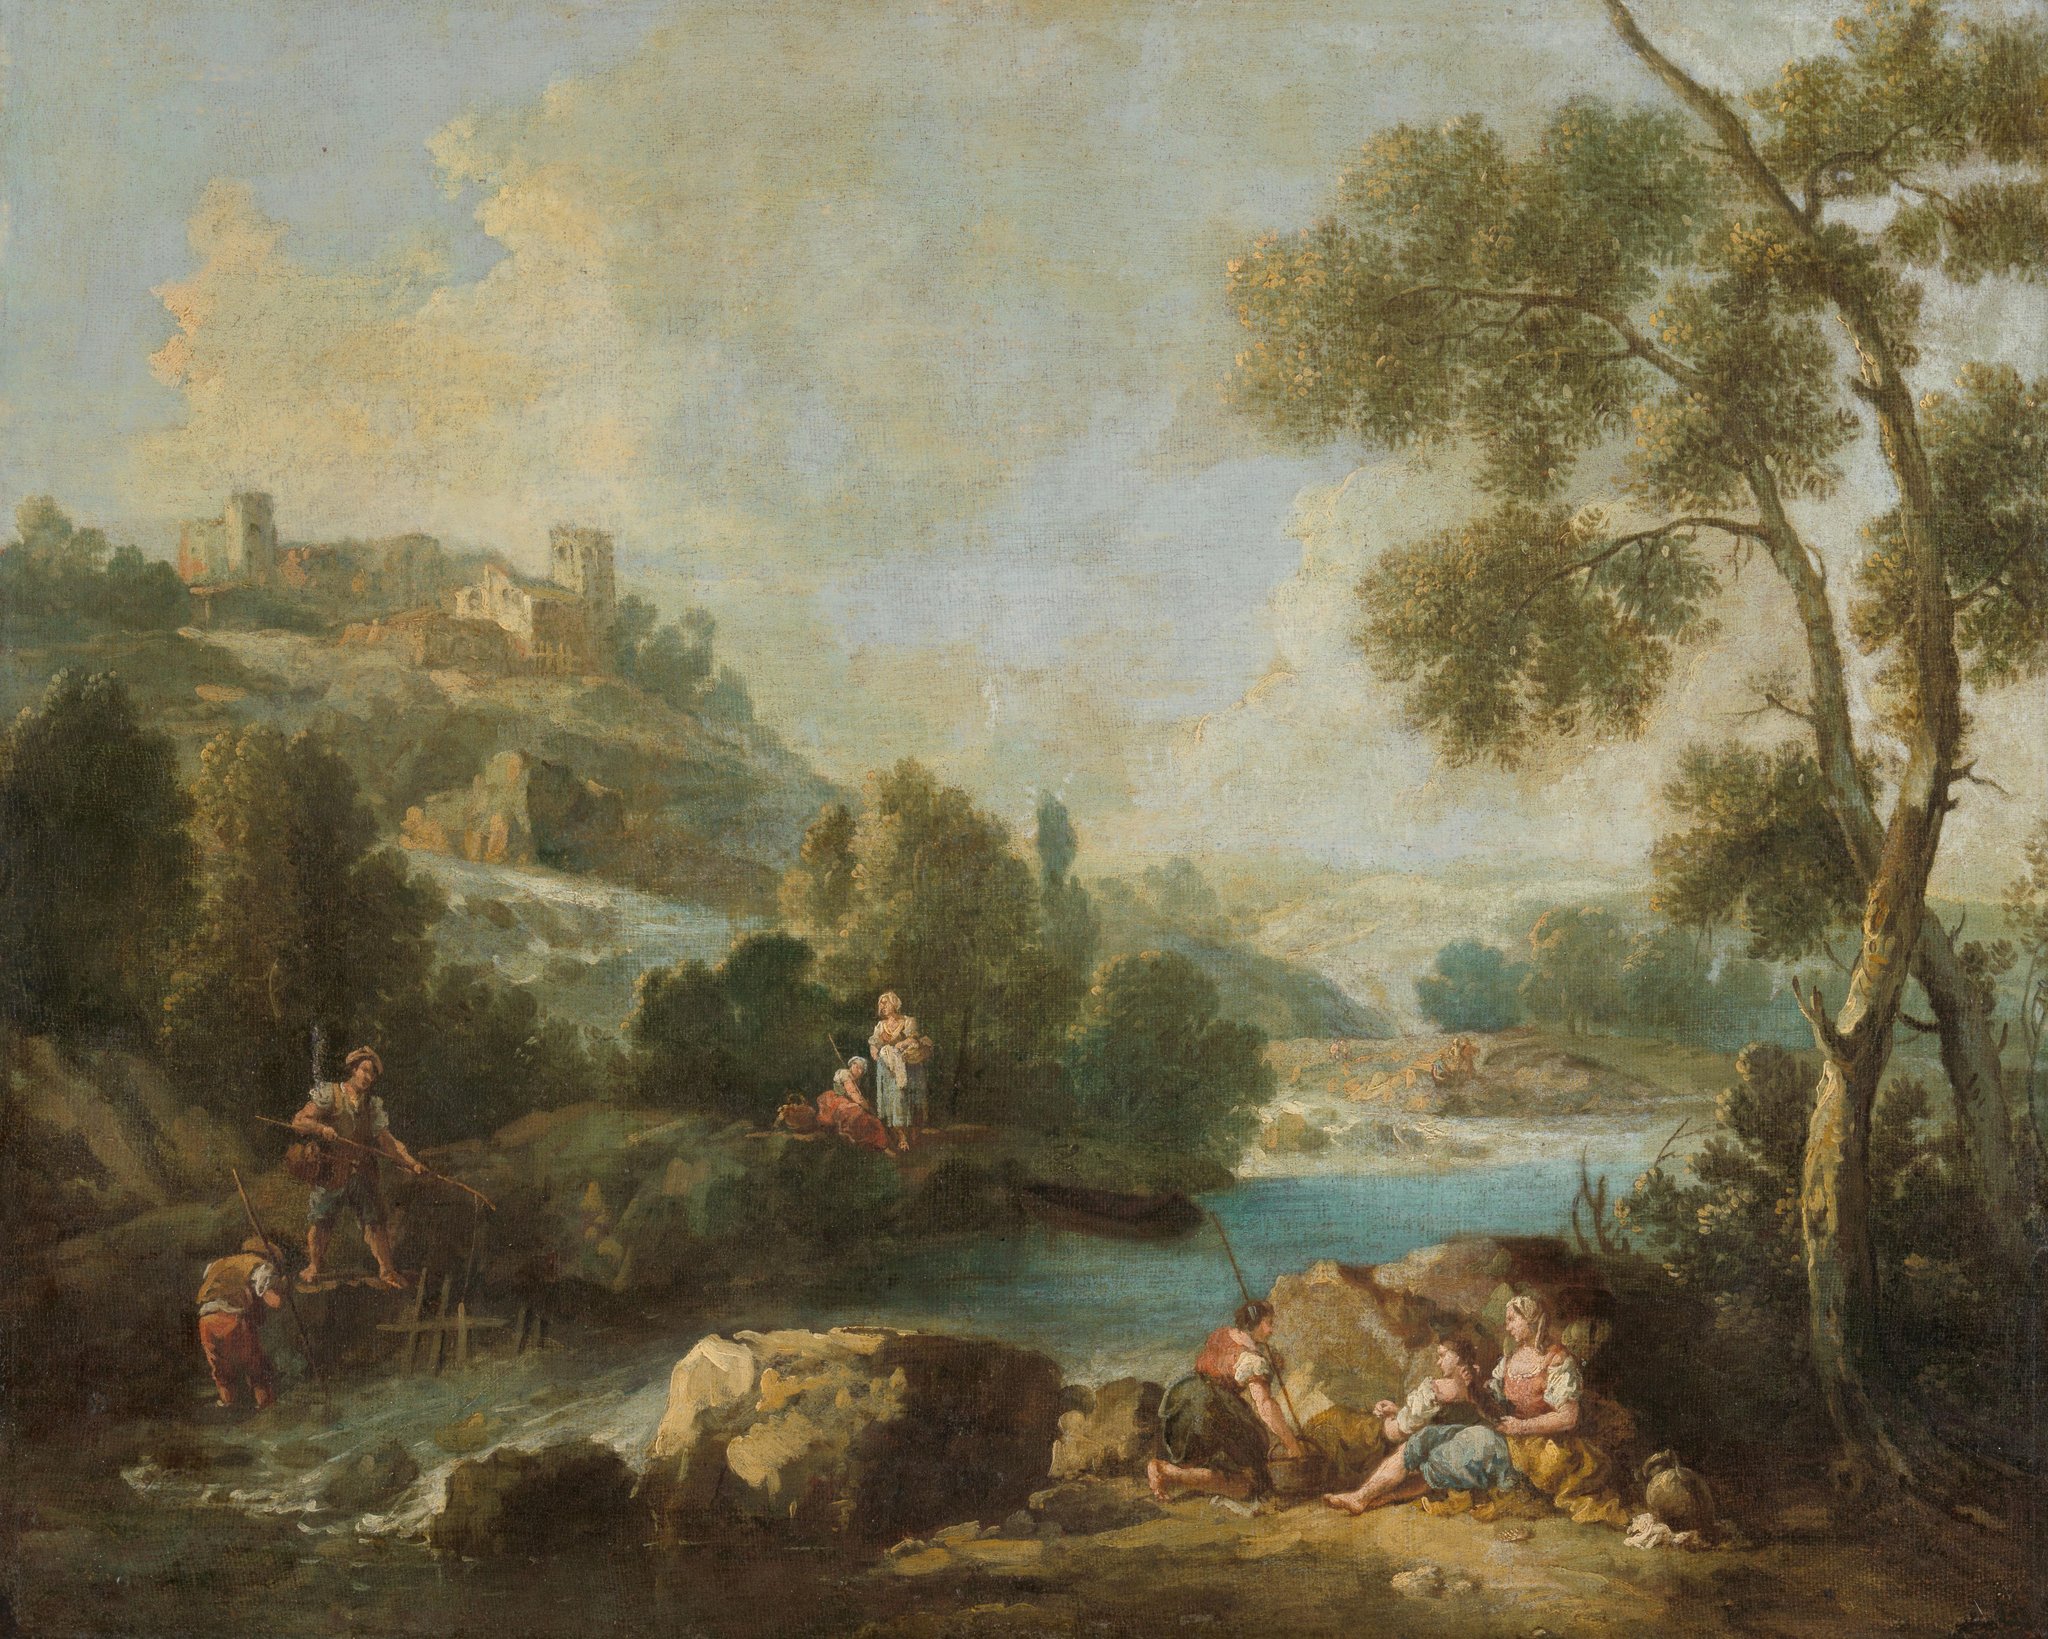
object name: painting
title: Landscape with Figures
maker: giuseppe zaïs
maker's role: draughtsman, painter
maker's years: 1709-1784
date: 1730-1770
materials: canvas, oil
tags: low hill country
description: Heuvellandschap met figuren. Rivierlandschap met op de voorgrond drie rustende vrouwen, aan de overzijde van een stroomversnelling staan twee mannen. In de verte een heuvel met enkele gebouwen,